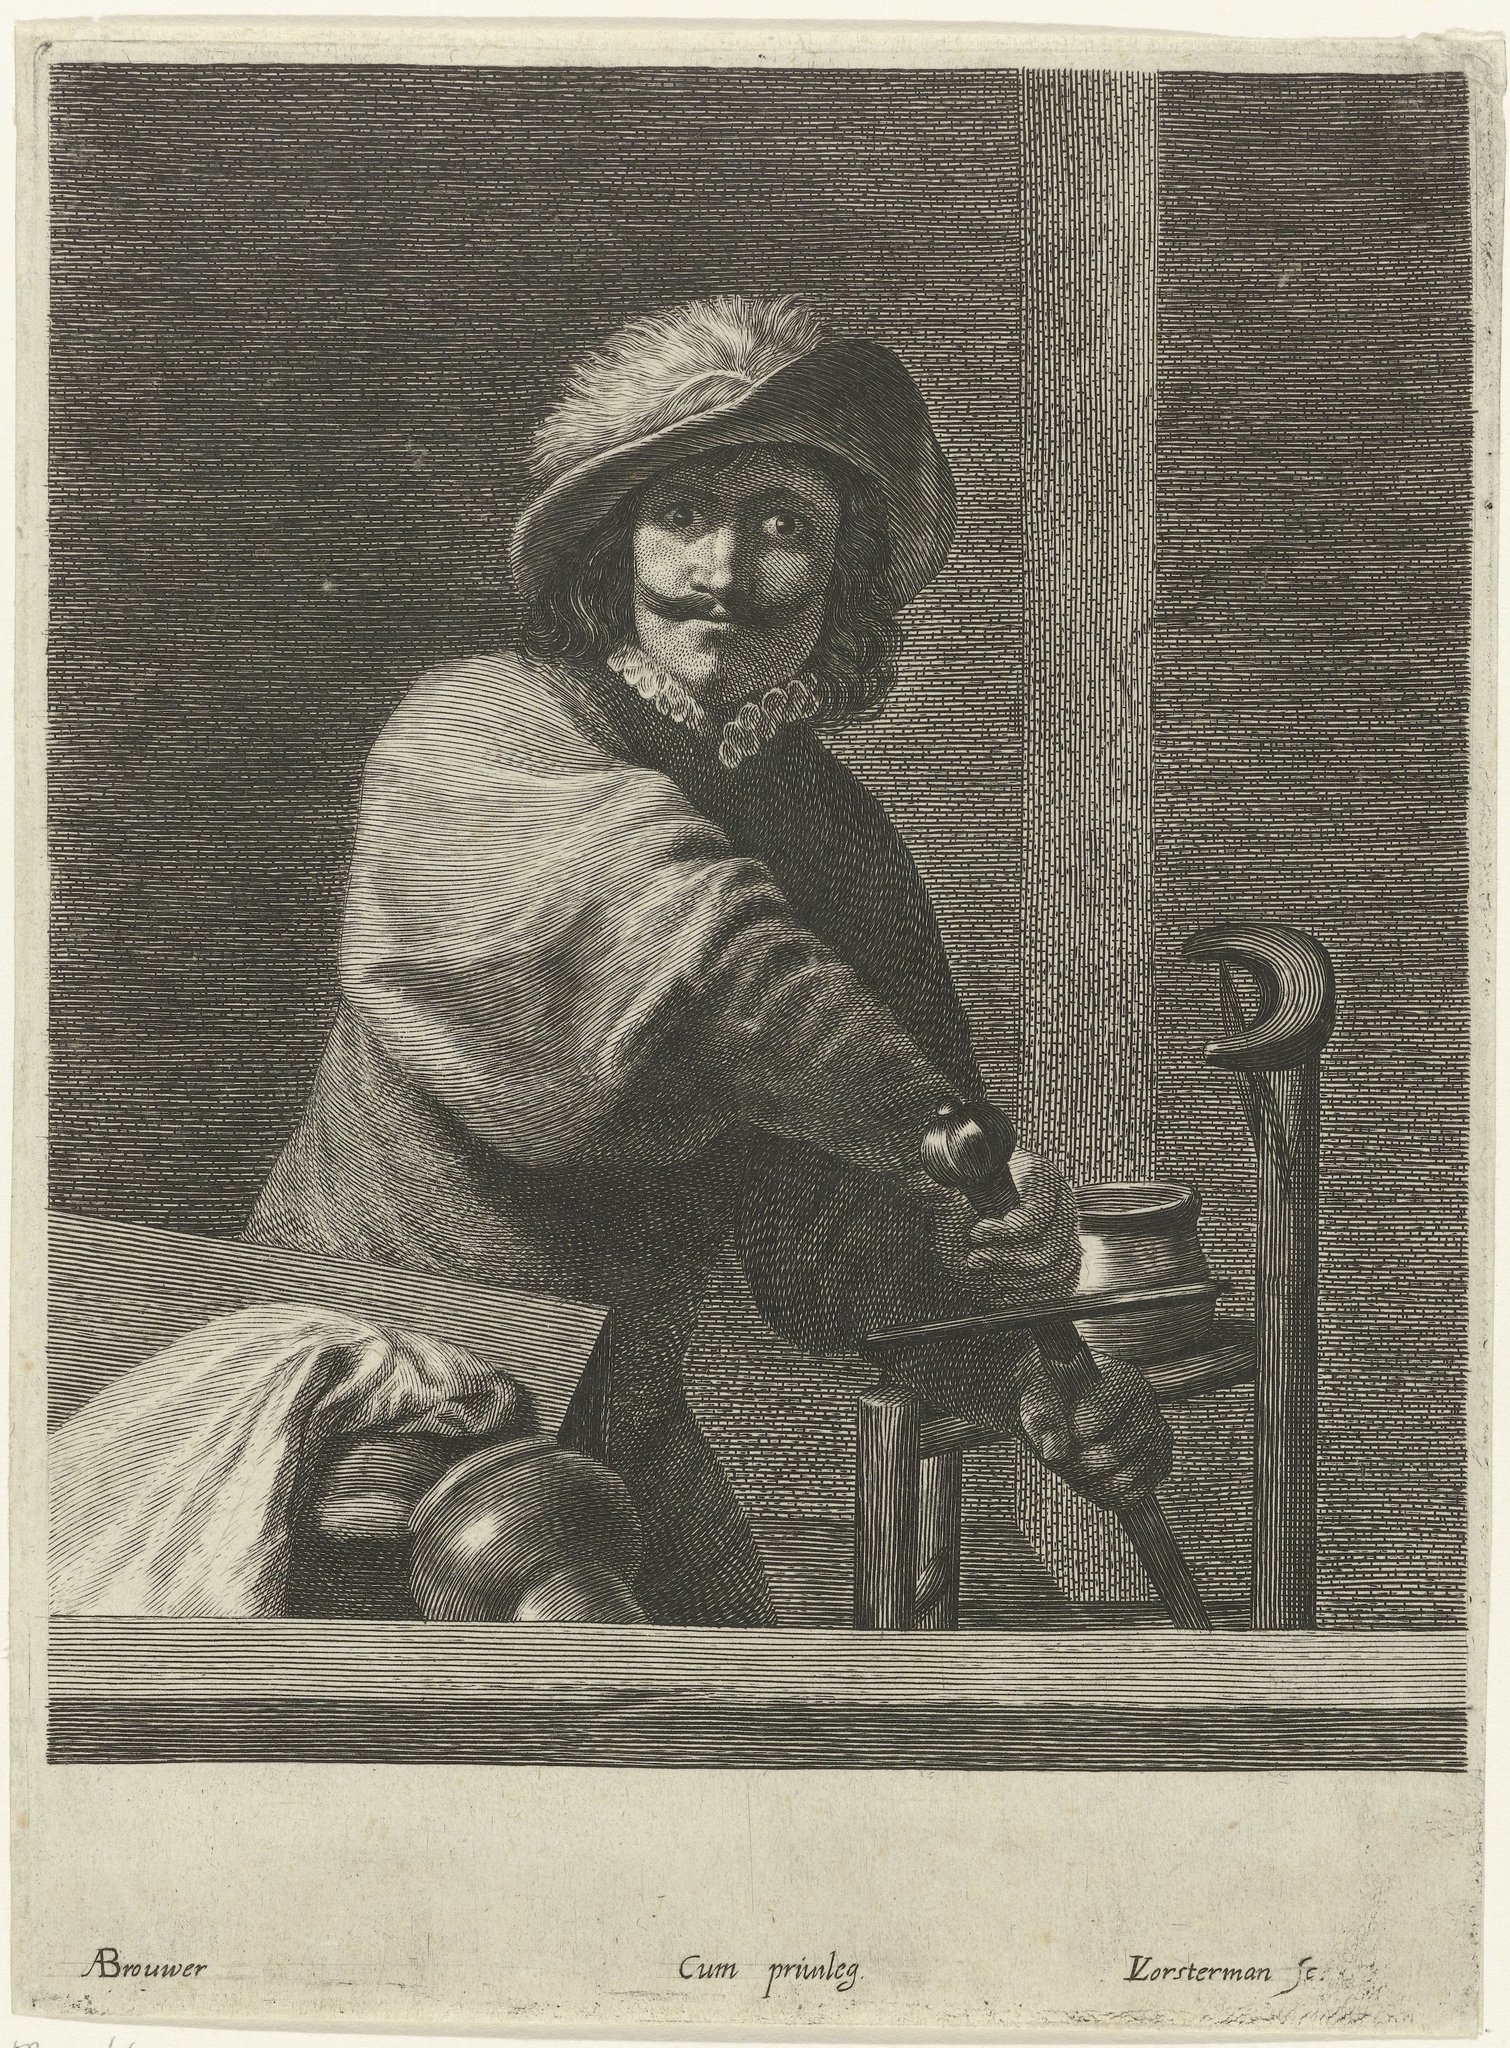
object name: print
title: De zeven hoofdzonden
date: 1619-1675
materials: paper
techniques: engraving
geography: antwerp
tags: anger; 'ira' (ripa) ~ personification of one of the seven deadly sins, hacking and thrusting weapons: sword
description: Een man trekt zijn zwaard, terwijl hij de tafel voor hem omstoot en er een kruik omvalt.